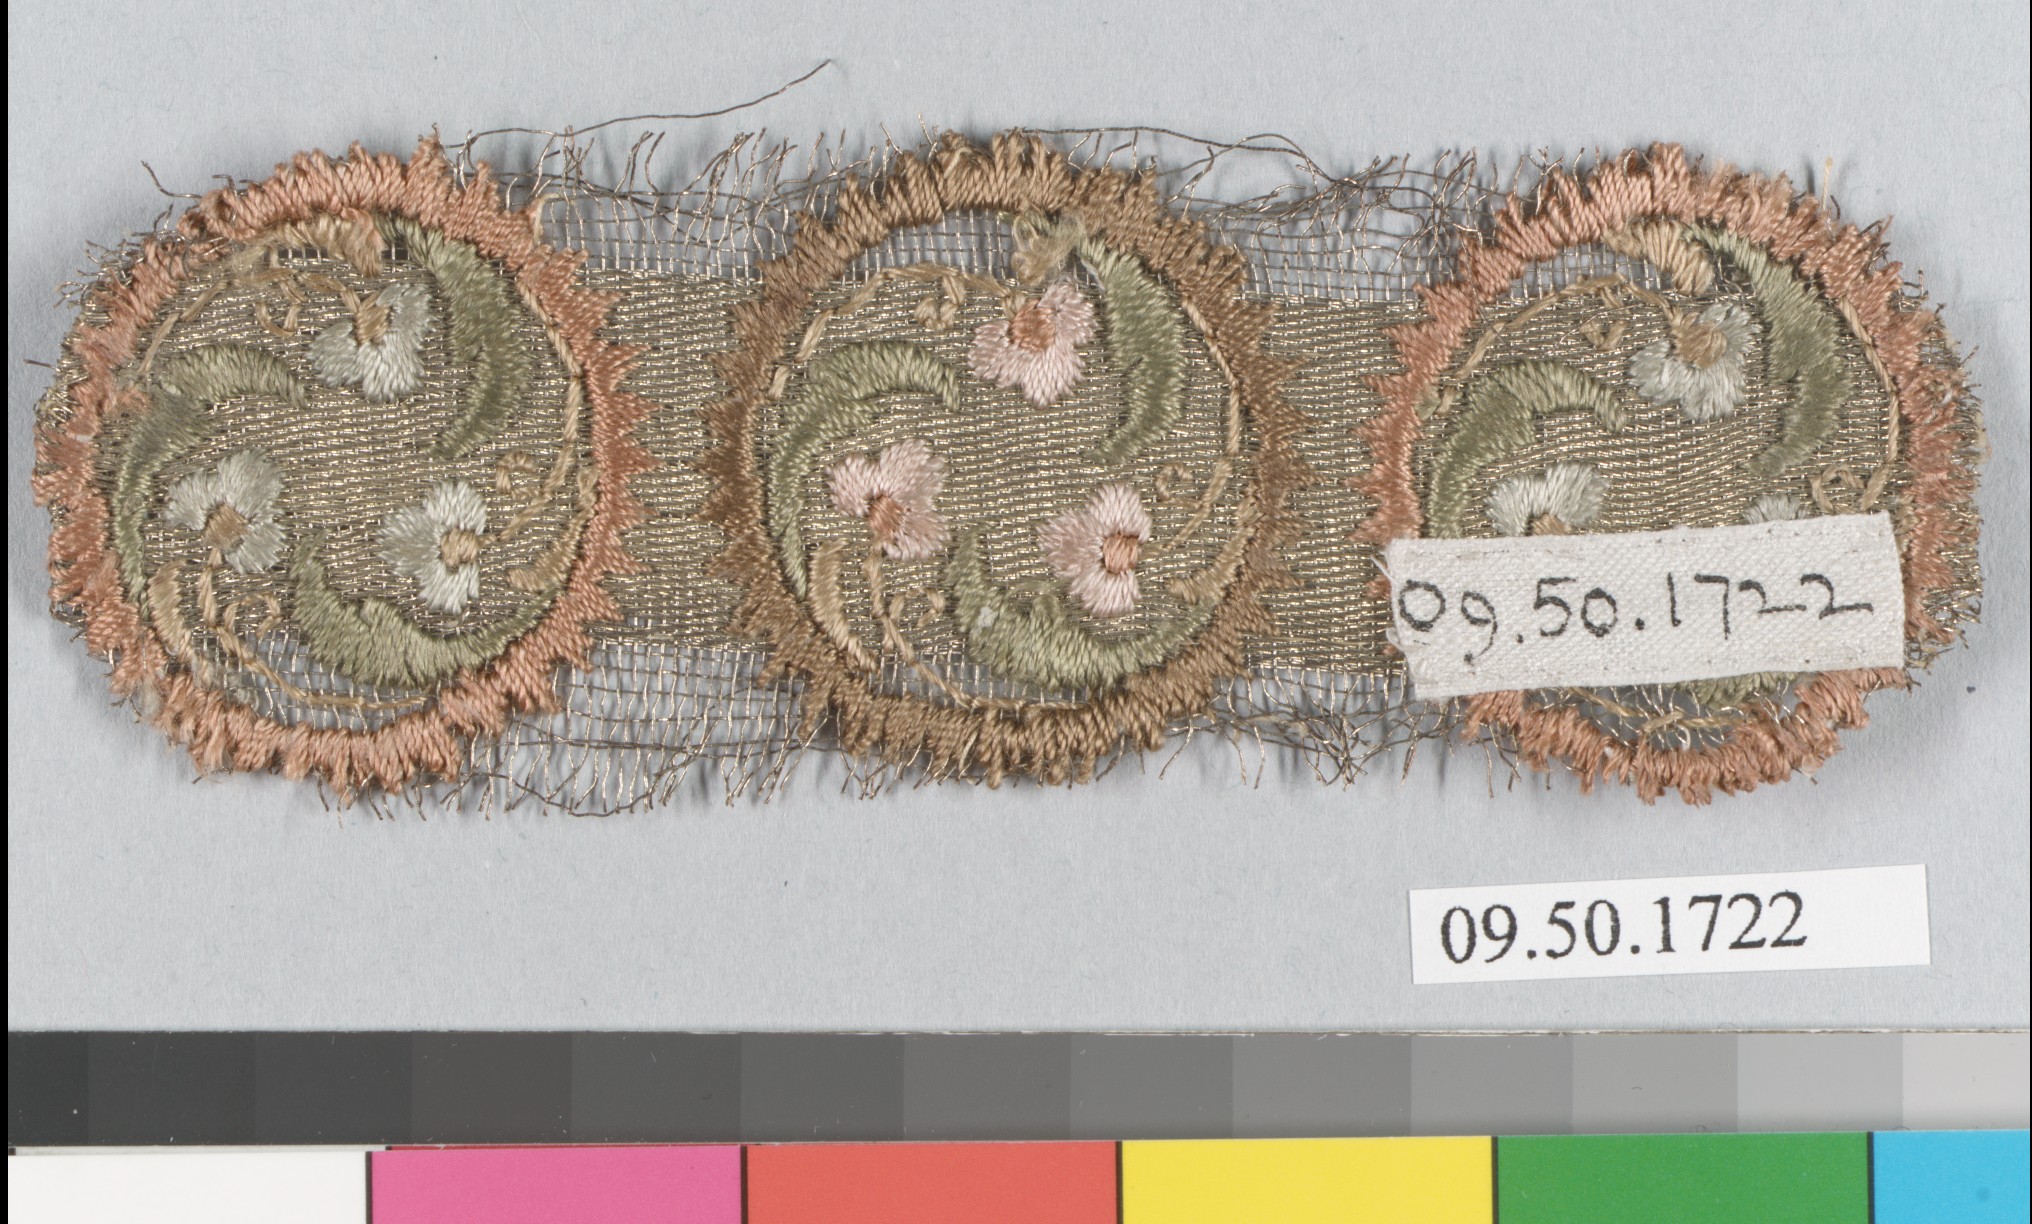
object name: passementerie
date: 1801-1900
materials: metal thread, silk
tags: flowers